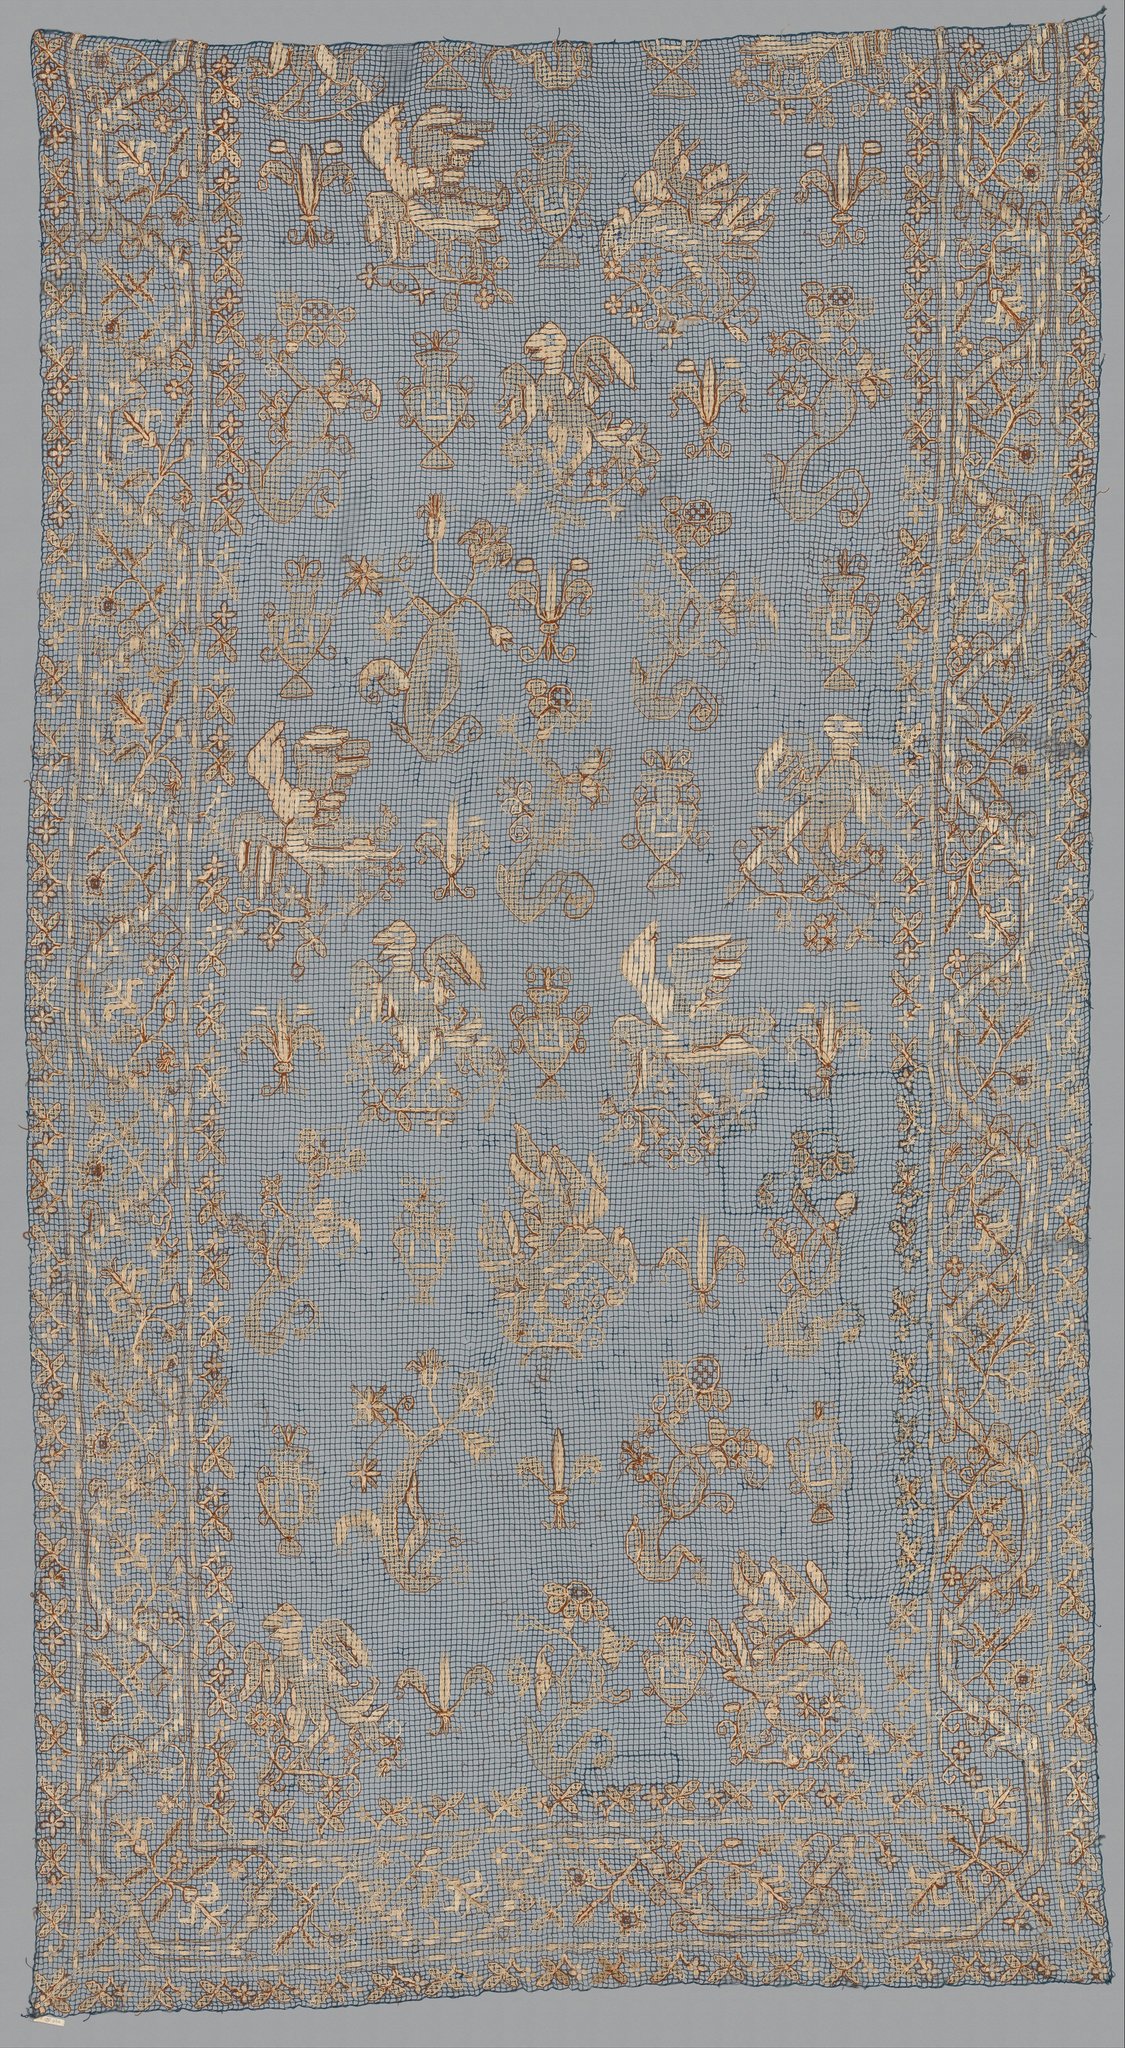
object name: curtain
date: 1601-1700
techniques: embroidery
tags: birds